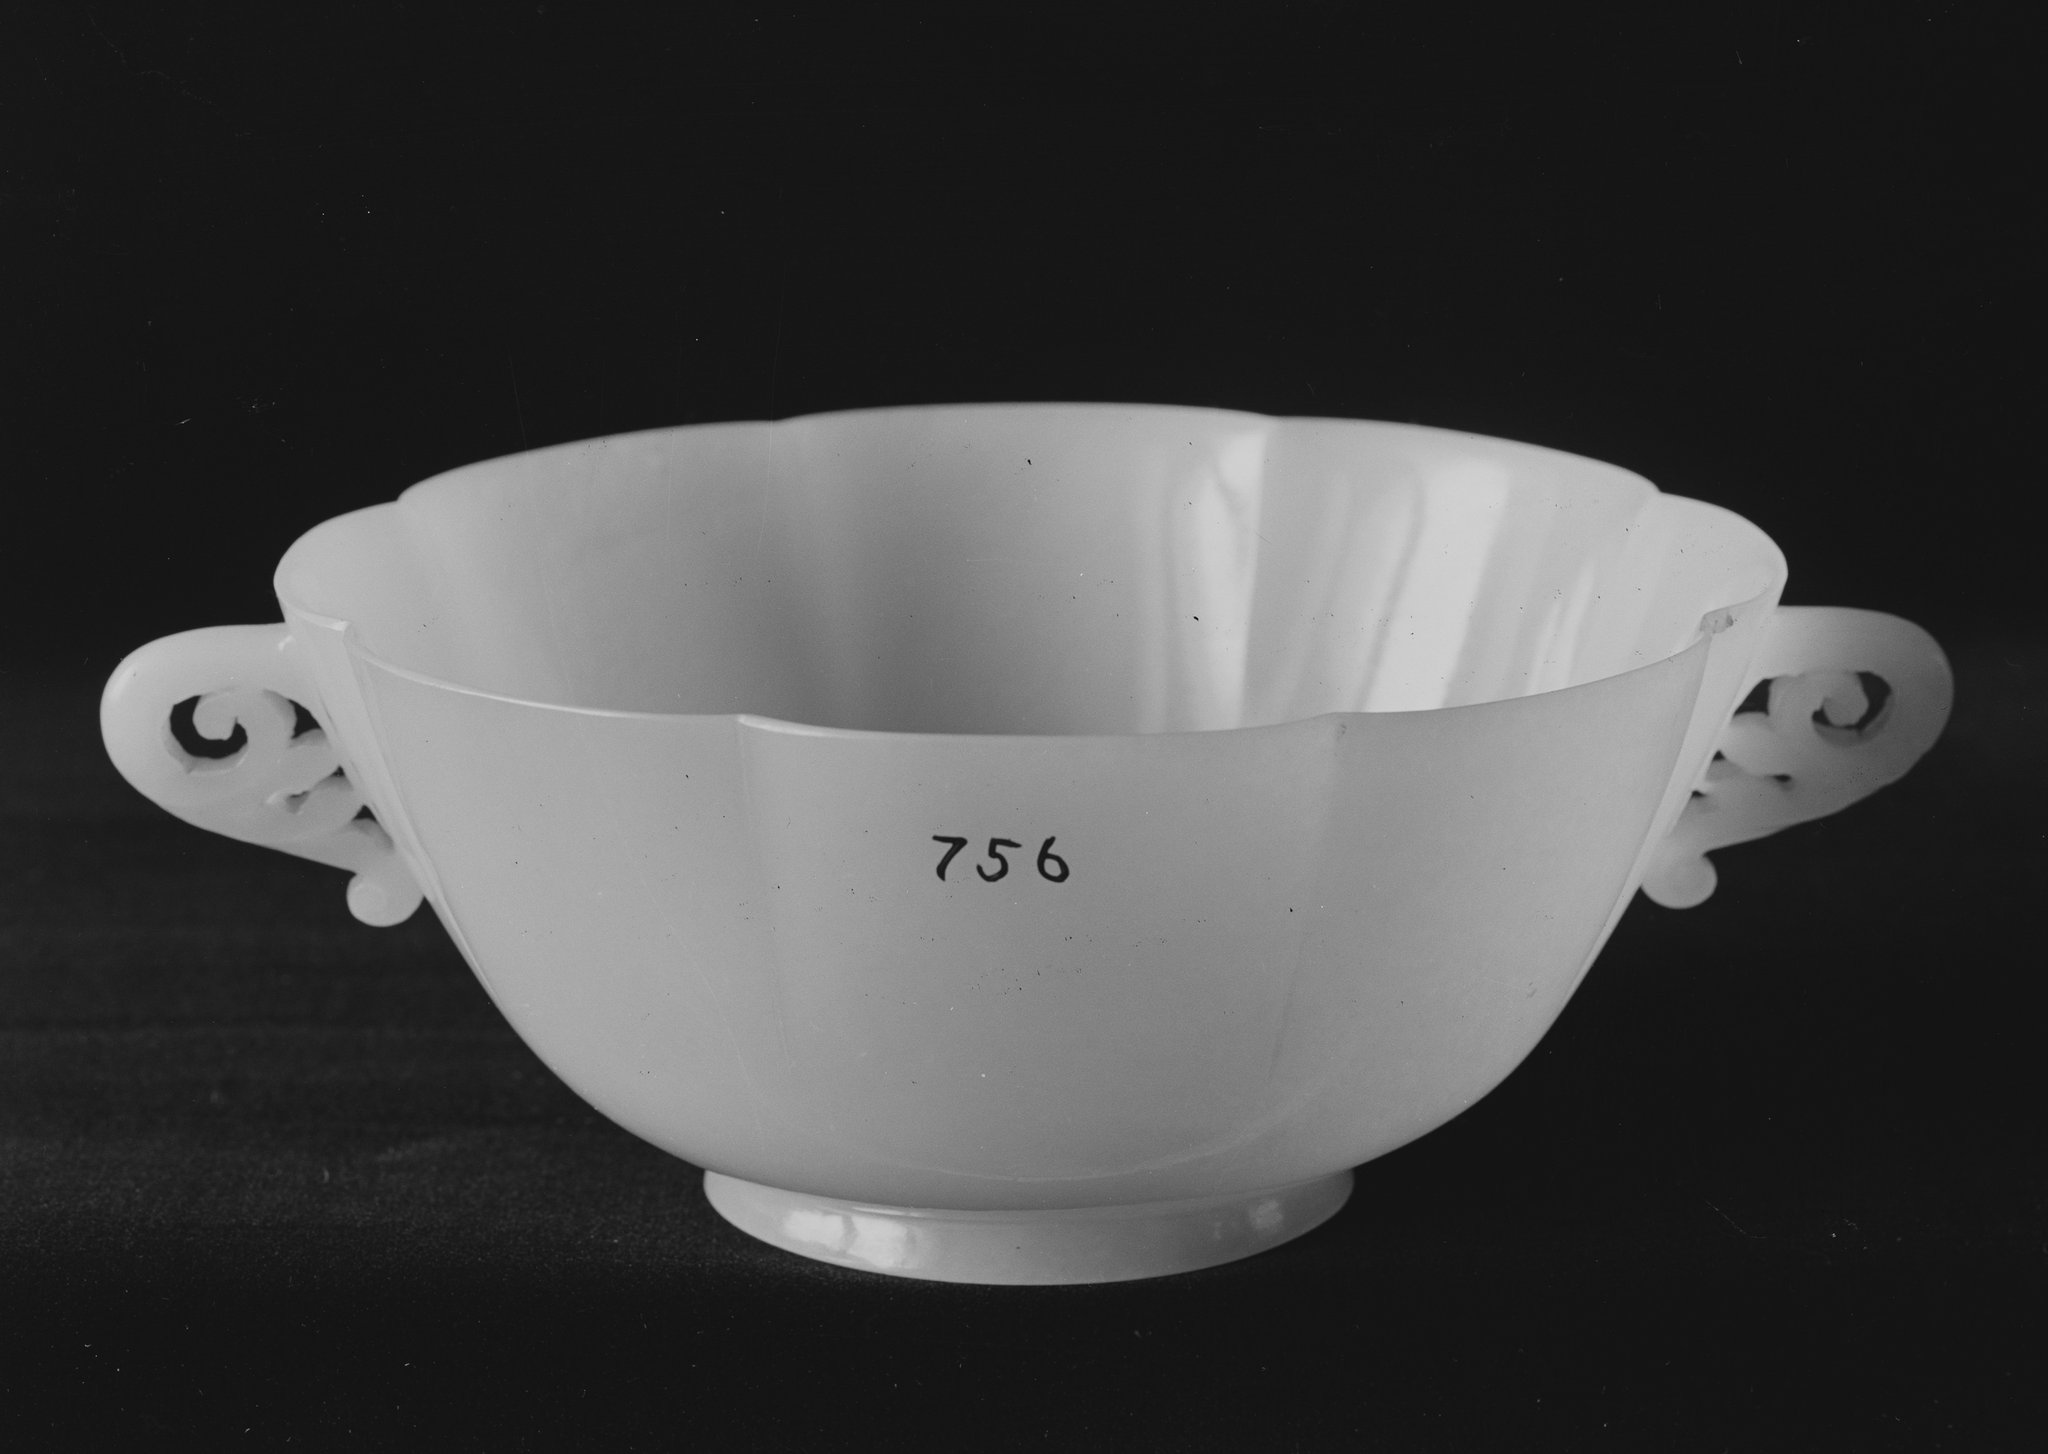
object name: bowl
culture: indian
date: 1601-1700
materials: jade